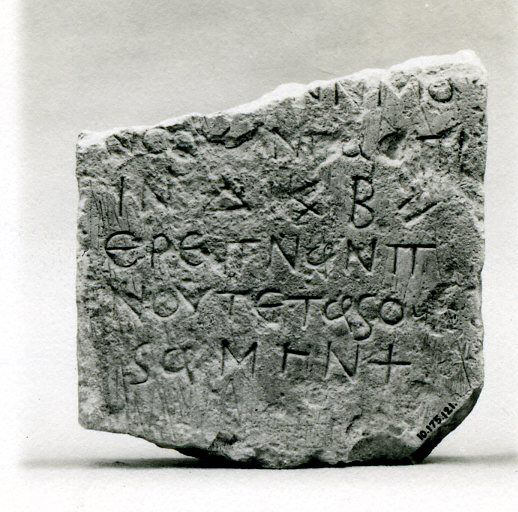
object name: fragment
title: Fragment of an Inscribed Stele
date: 501-700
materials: limestone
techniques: incising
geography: egypt